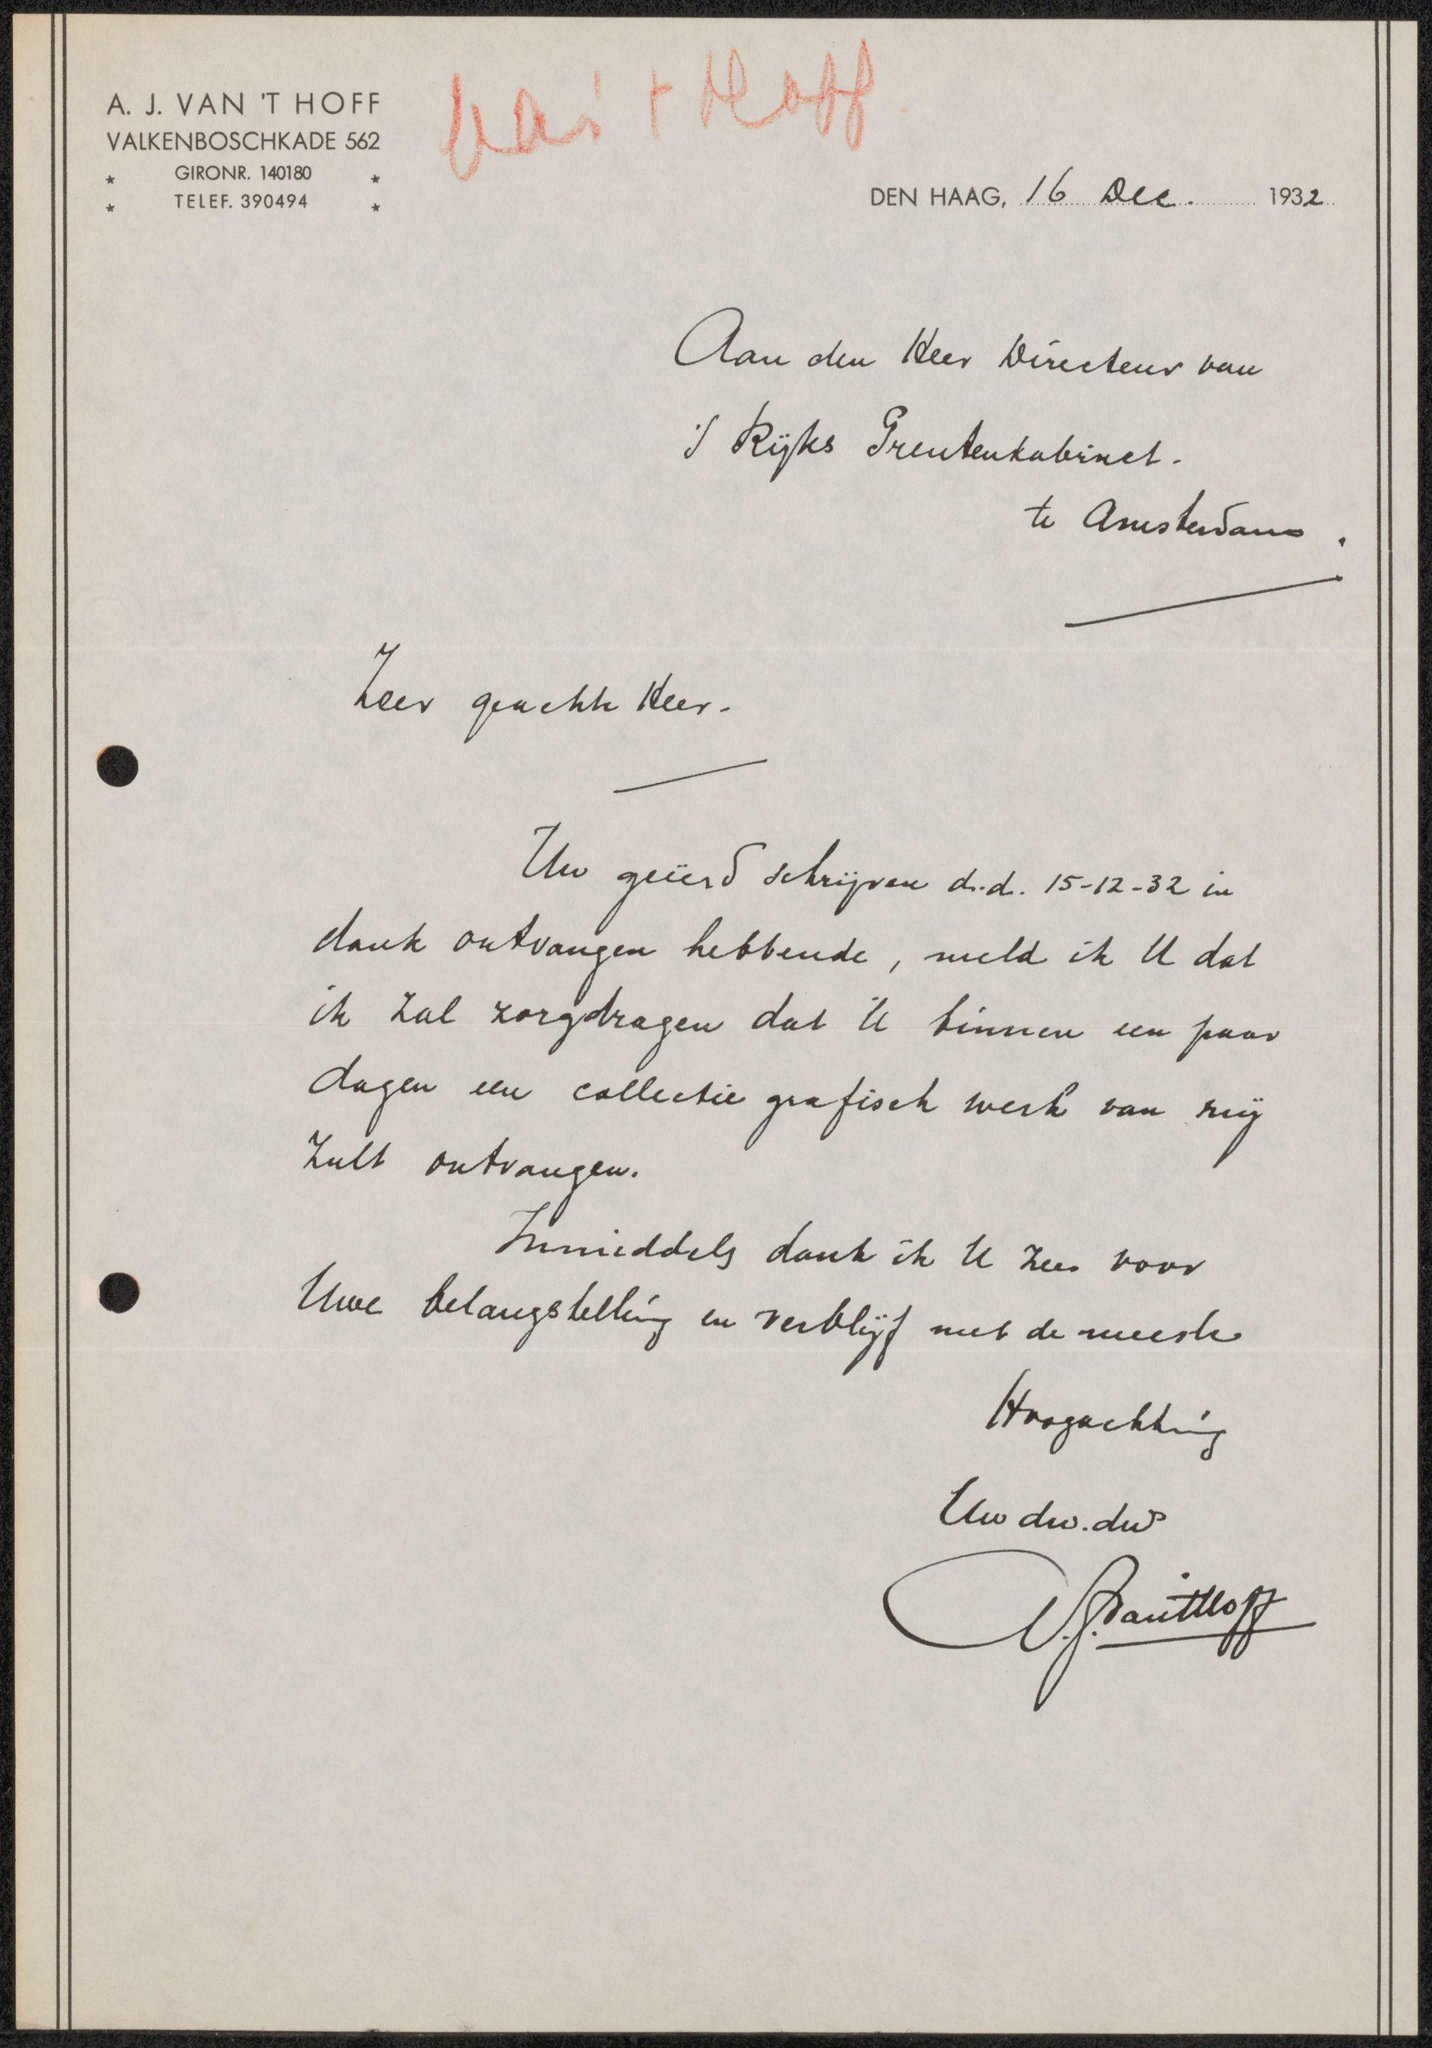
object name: letter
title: Brief aan jonkheer Hendrik Teding van Berkhout (1879-1969)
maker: adriaan j. van t hoff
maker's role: draughtsman, print maker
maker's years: 1893-1939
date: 1932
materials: ink, paper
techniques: pen, printing, writing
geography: the hague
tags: print room, haarlem, jonkheer hendrik teding van berkhout (1879-1969), the graphic arts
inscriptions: watermark